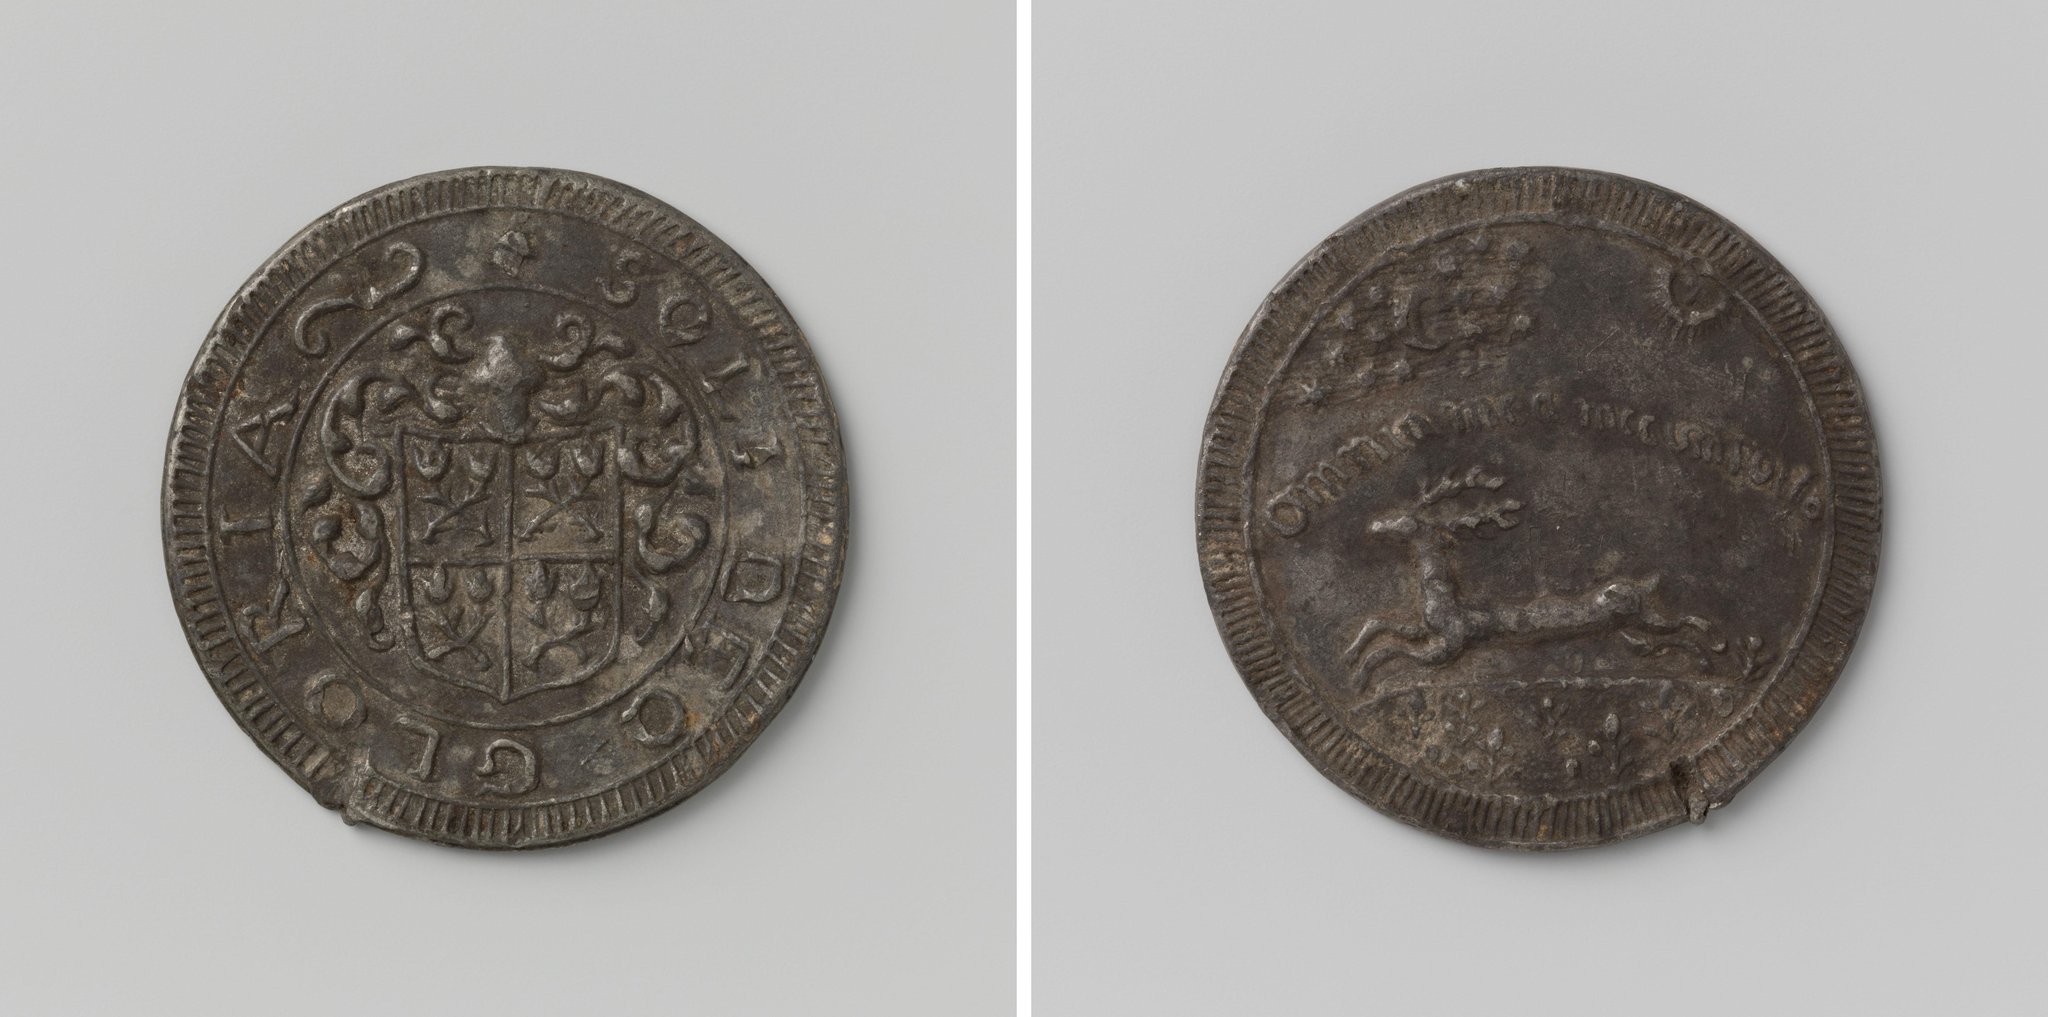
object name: medal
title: Penning van lood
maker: Anonymous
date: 1650-1750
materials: lead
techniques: casting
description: Loden penning. Voorzijde: naar links rennend hert onder opschrift, maan met sterren en stralende zon. Keerzijde: gehelmd wapenschild binnen omschrift.